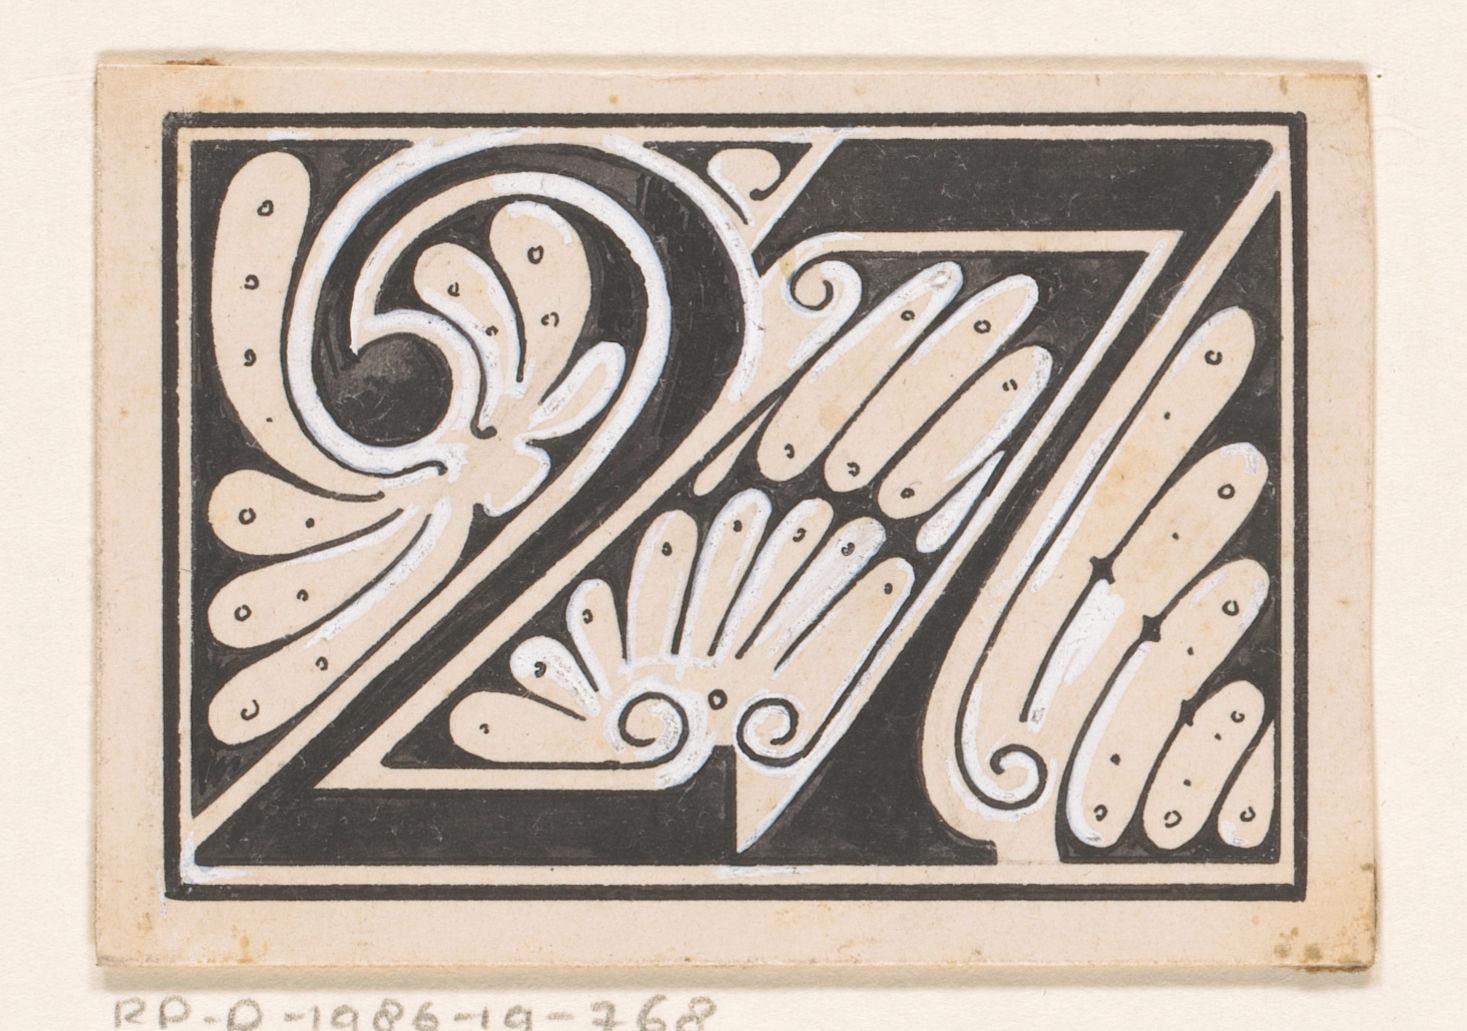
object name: design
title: Getal 27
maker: reinier willem petrus de vries (1874-1953)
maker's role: draughtsman, print maker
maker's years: 1874-1953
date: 1904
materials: paint, ink, paper, pencil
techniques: brush, pen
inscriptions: collector's mark: ‘R:MVS.’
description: Het getal is gebruikt voor: Veth, Jan. Jozef Israëls en zijn kunst. Arnhem en Nijmegen: Gebroeders E&M Cohen, 1904.